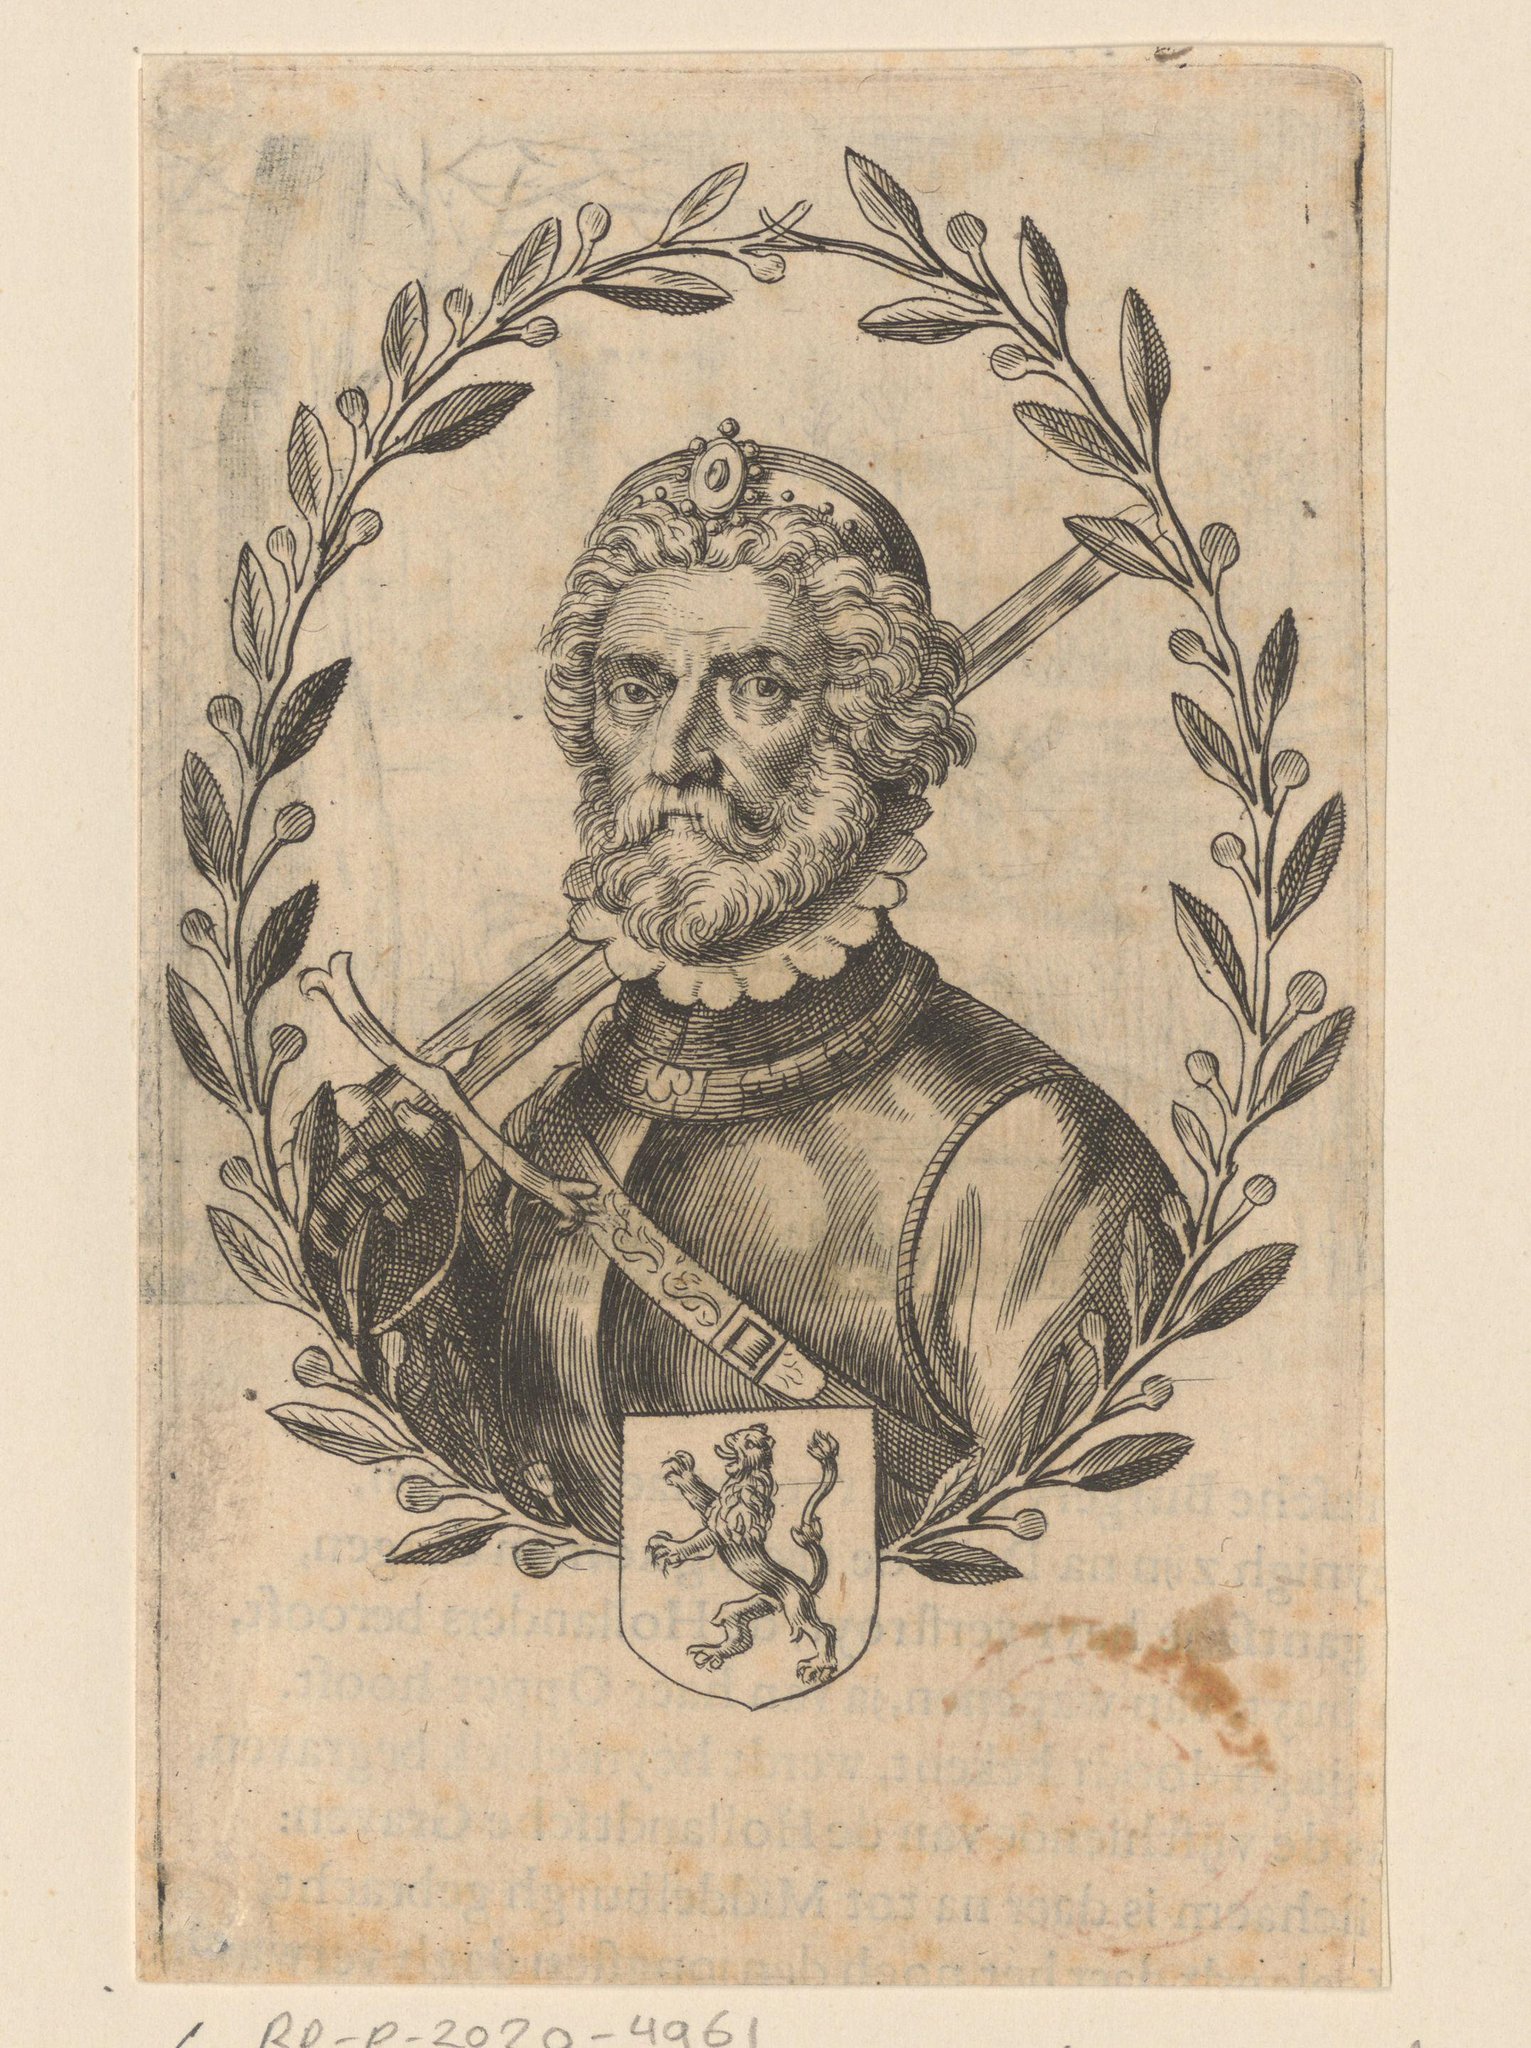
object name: print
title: Portret van Floris V, graaf van Holland en Zeeland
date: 1645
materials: paper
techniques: engraving, etching, letterpress printing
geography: northern netherlands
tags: leiden, floris v (graaf van holland en zeeland), earl, coat of arms (as symbol of the state, etc.), historical persons, hacking and thrusting weapons: sword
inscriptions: collector's mark: Lugt 240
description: Prent uit: Wachtendorp, Casparus. Oude Hollandsche Geschiedenissen ofte, corte Rym-Kronyck (...). Amsterdam: Johannes Pauli, 1645. Latere staat gebruikt in 'Hollandsche, Zeelandsche ende Vriesche Chronyck (...)' van Scriverius, 1678.